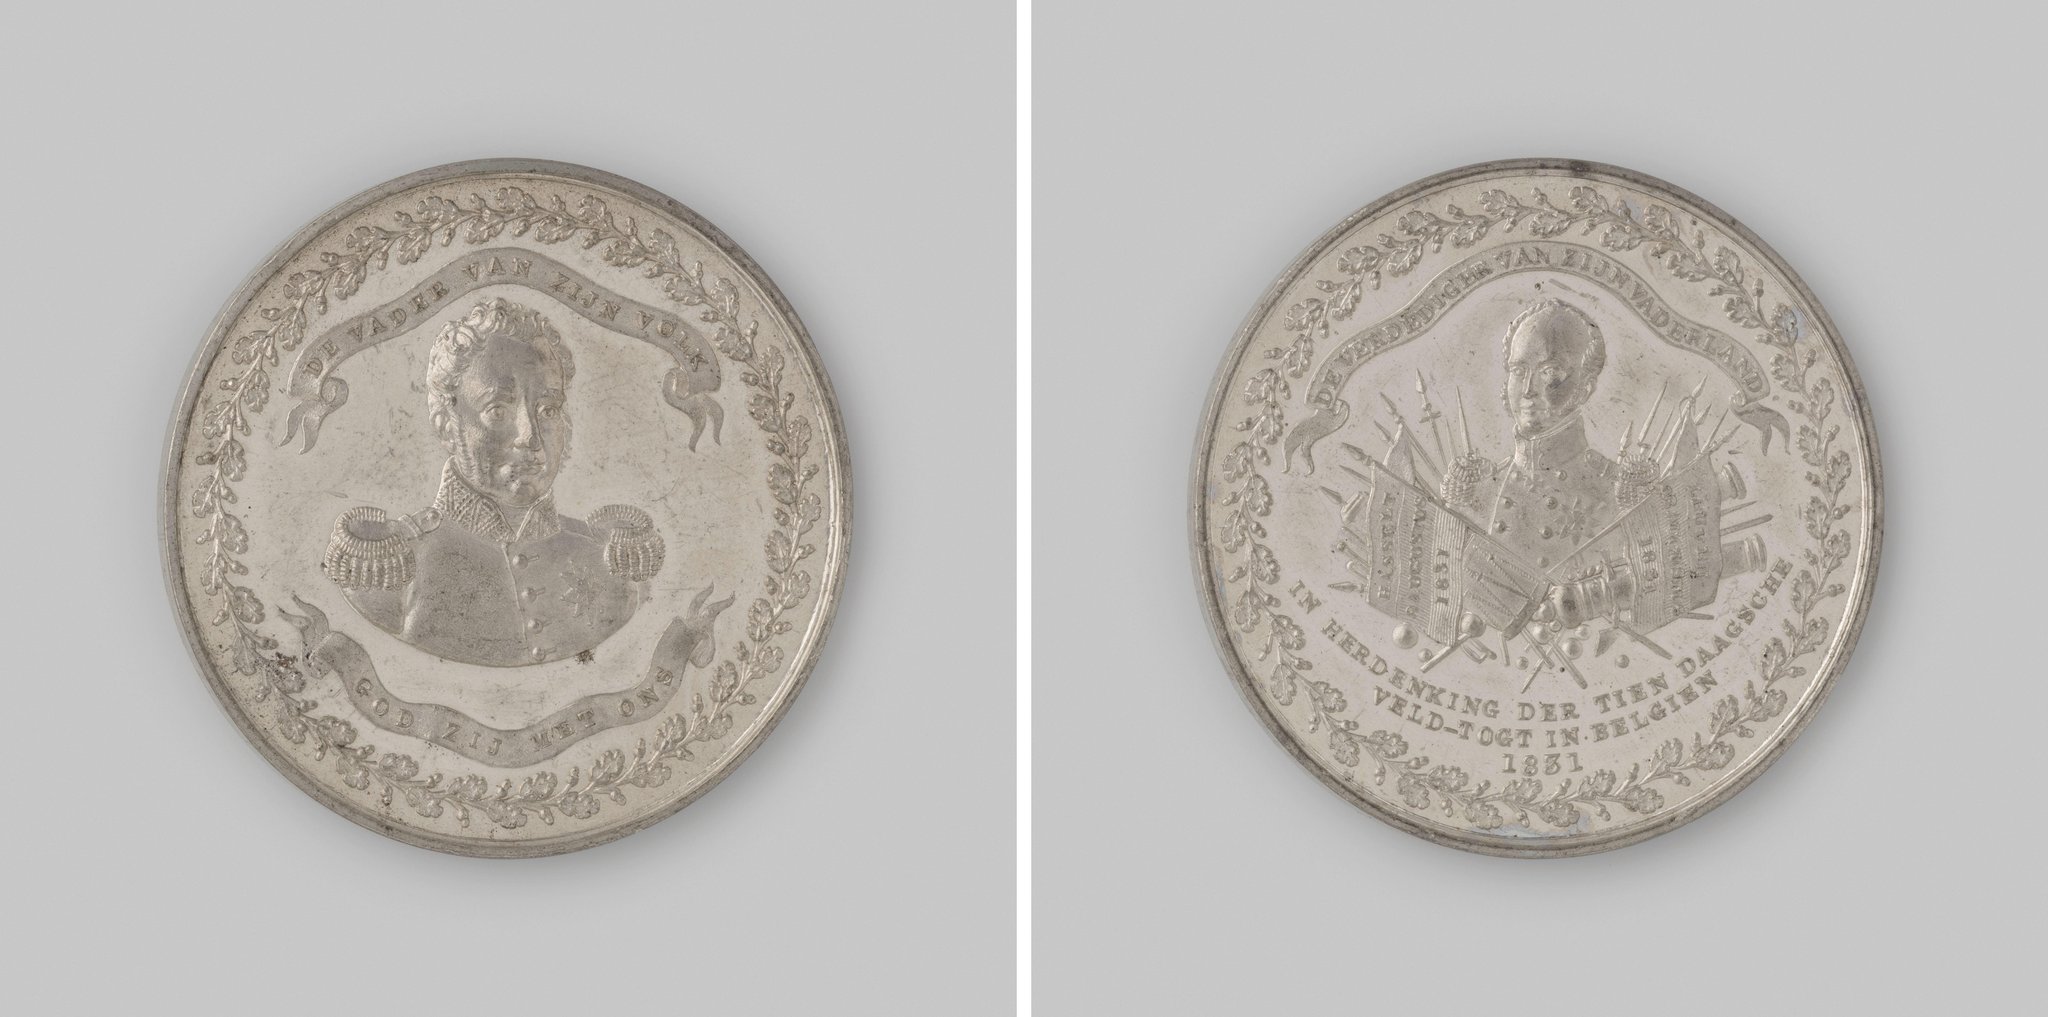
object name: history medal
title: Tiendaagse veldtocht 1831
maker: johannis petrus schouberg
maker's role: die cutter, draughtsman, print maker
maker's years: 1798-1864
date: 1831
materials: tin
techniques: striking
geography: utrecht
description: Tinnen penning, op de voorzijde het borstbeeld van Koning Willem I half naar rechts, onder en boven een tekstlint, binnen een eikenkrans, op de keerzijde het borstbeeld van de kroonprins half naar links, te midden van militaire attributen en onder een tekstlint, boven drie regels tekst, binnen een eikenkrans.